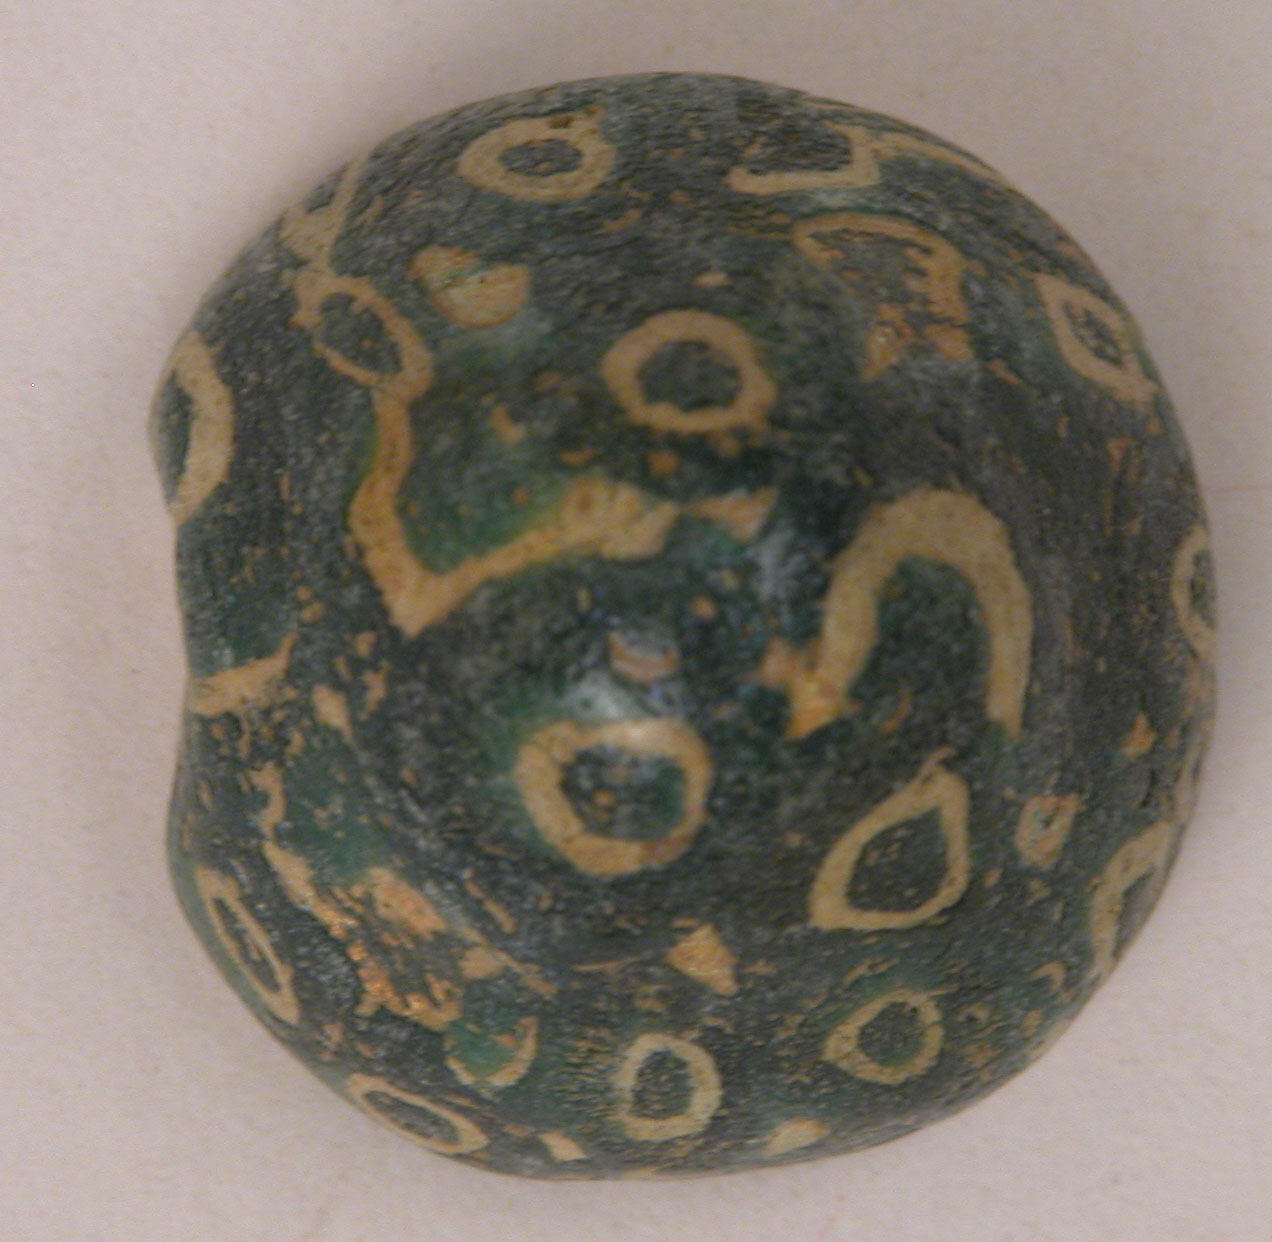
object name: gaming piece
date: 701-1200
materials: glass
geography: islamic lands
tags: games